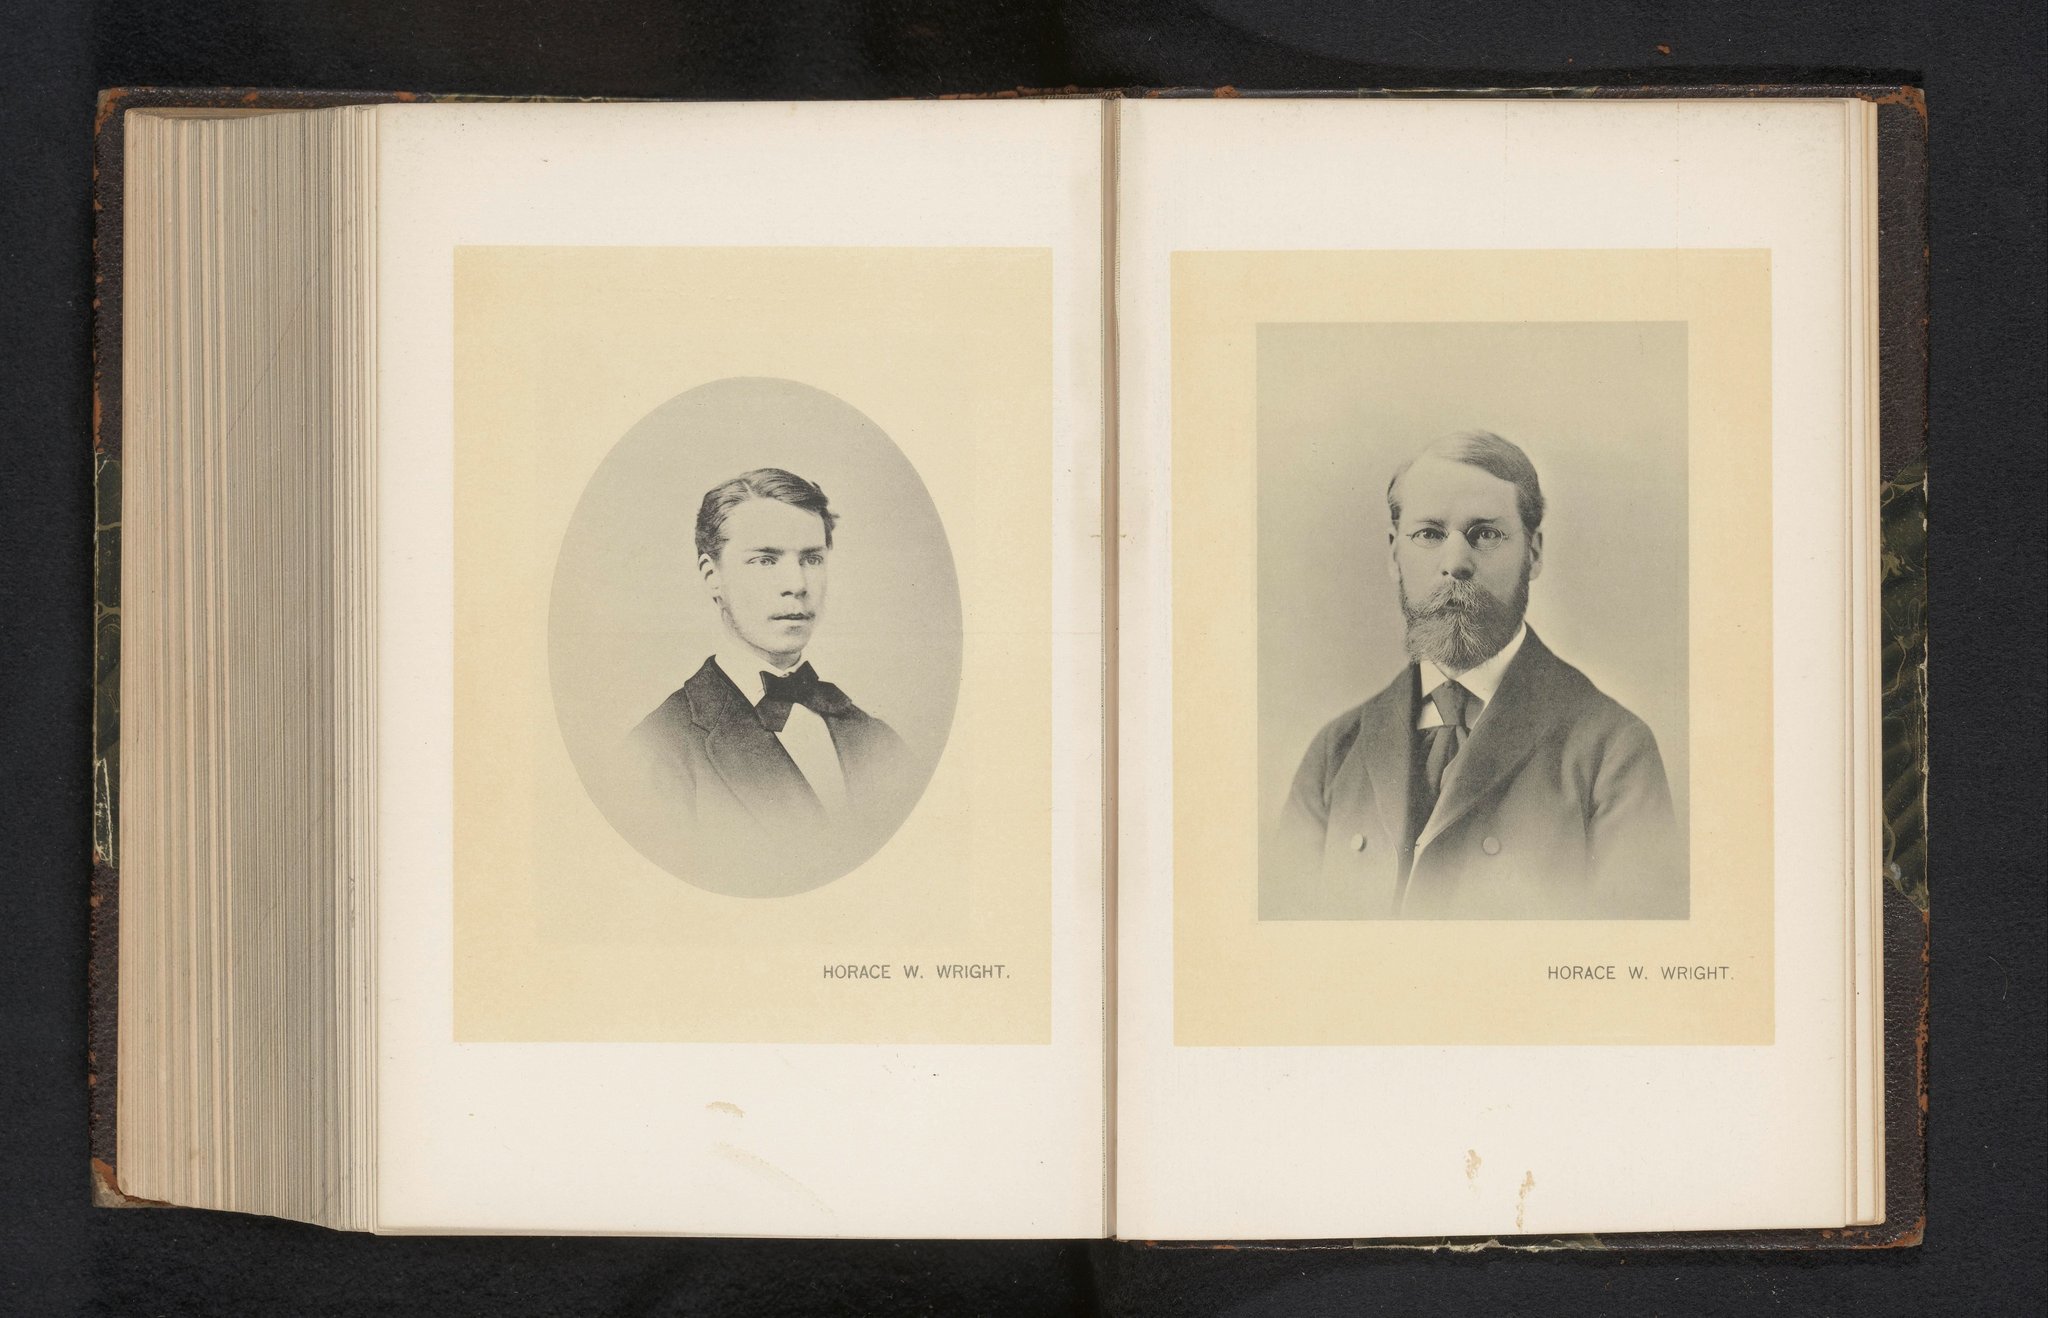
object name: page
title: Horace W. Wright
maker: Anonymous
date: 1889-1894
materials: paper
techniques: photoaquatint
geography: boston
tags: adult man